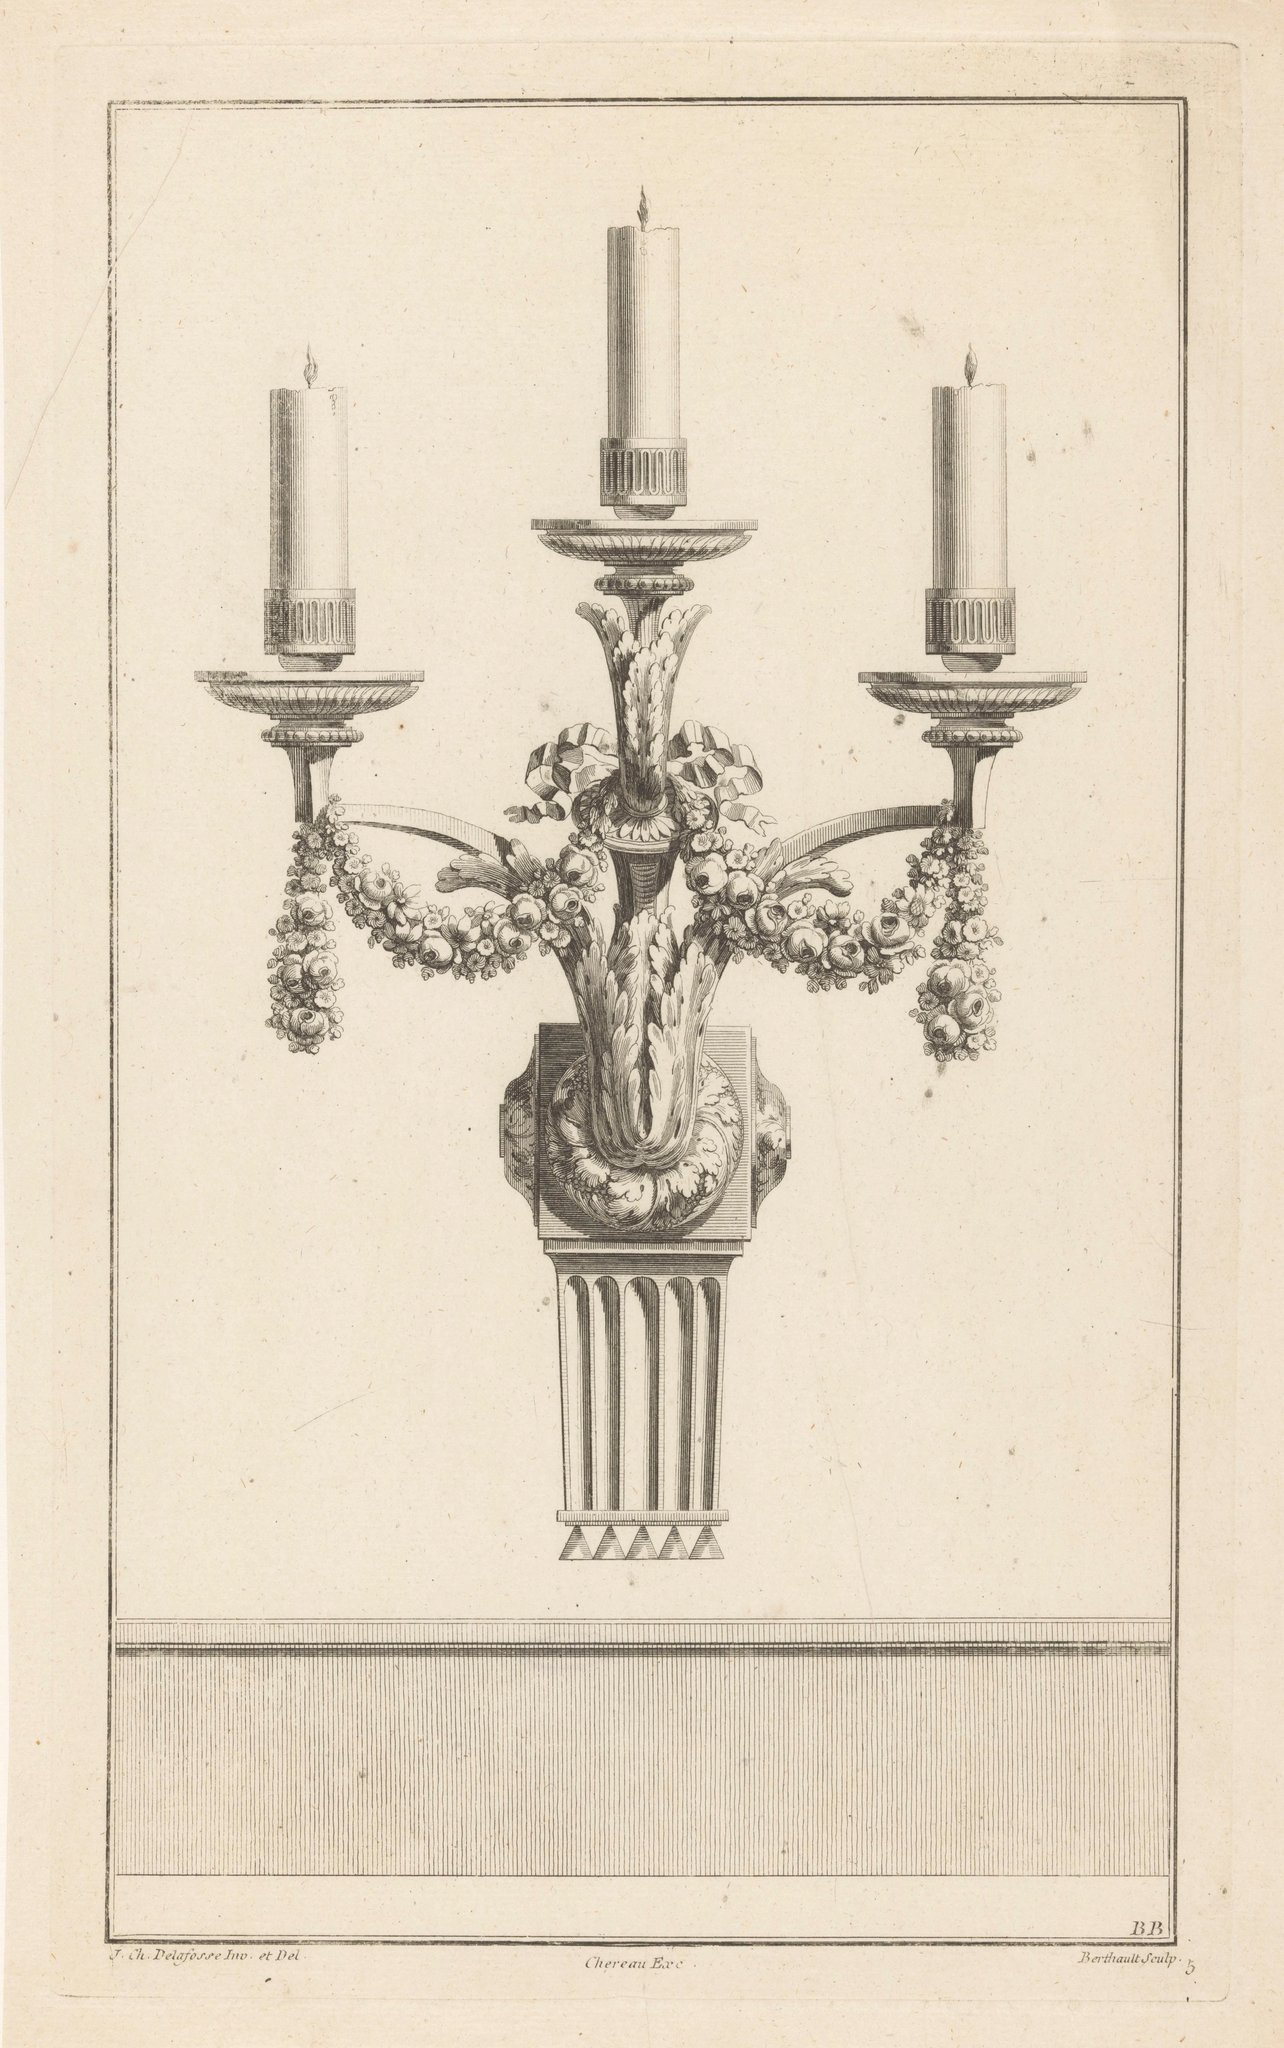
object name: print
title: IIe Volume De l'Oeuvre de J. Ch. Delafosse (...)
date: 1771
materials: paper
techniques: engraving, etching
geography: paris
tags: chandelier, candelabrum, ornament ~ festoon, garland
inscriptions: collector's mark: Lugt 2228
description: Een geornamenteerde driearmige girandole met bloemenguirlandes.